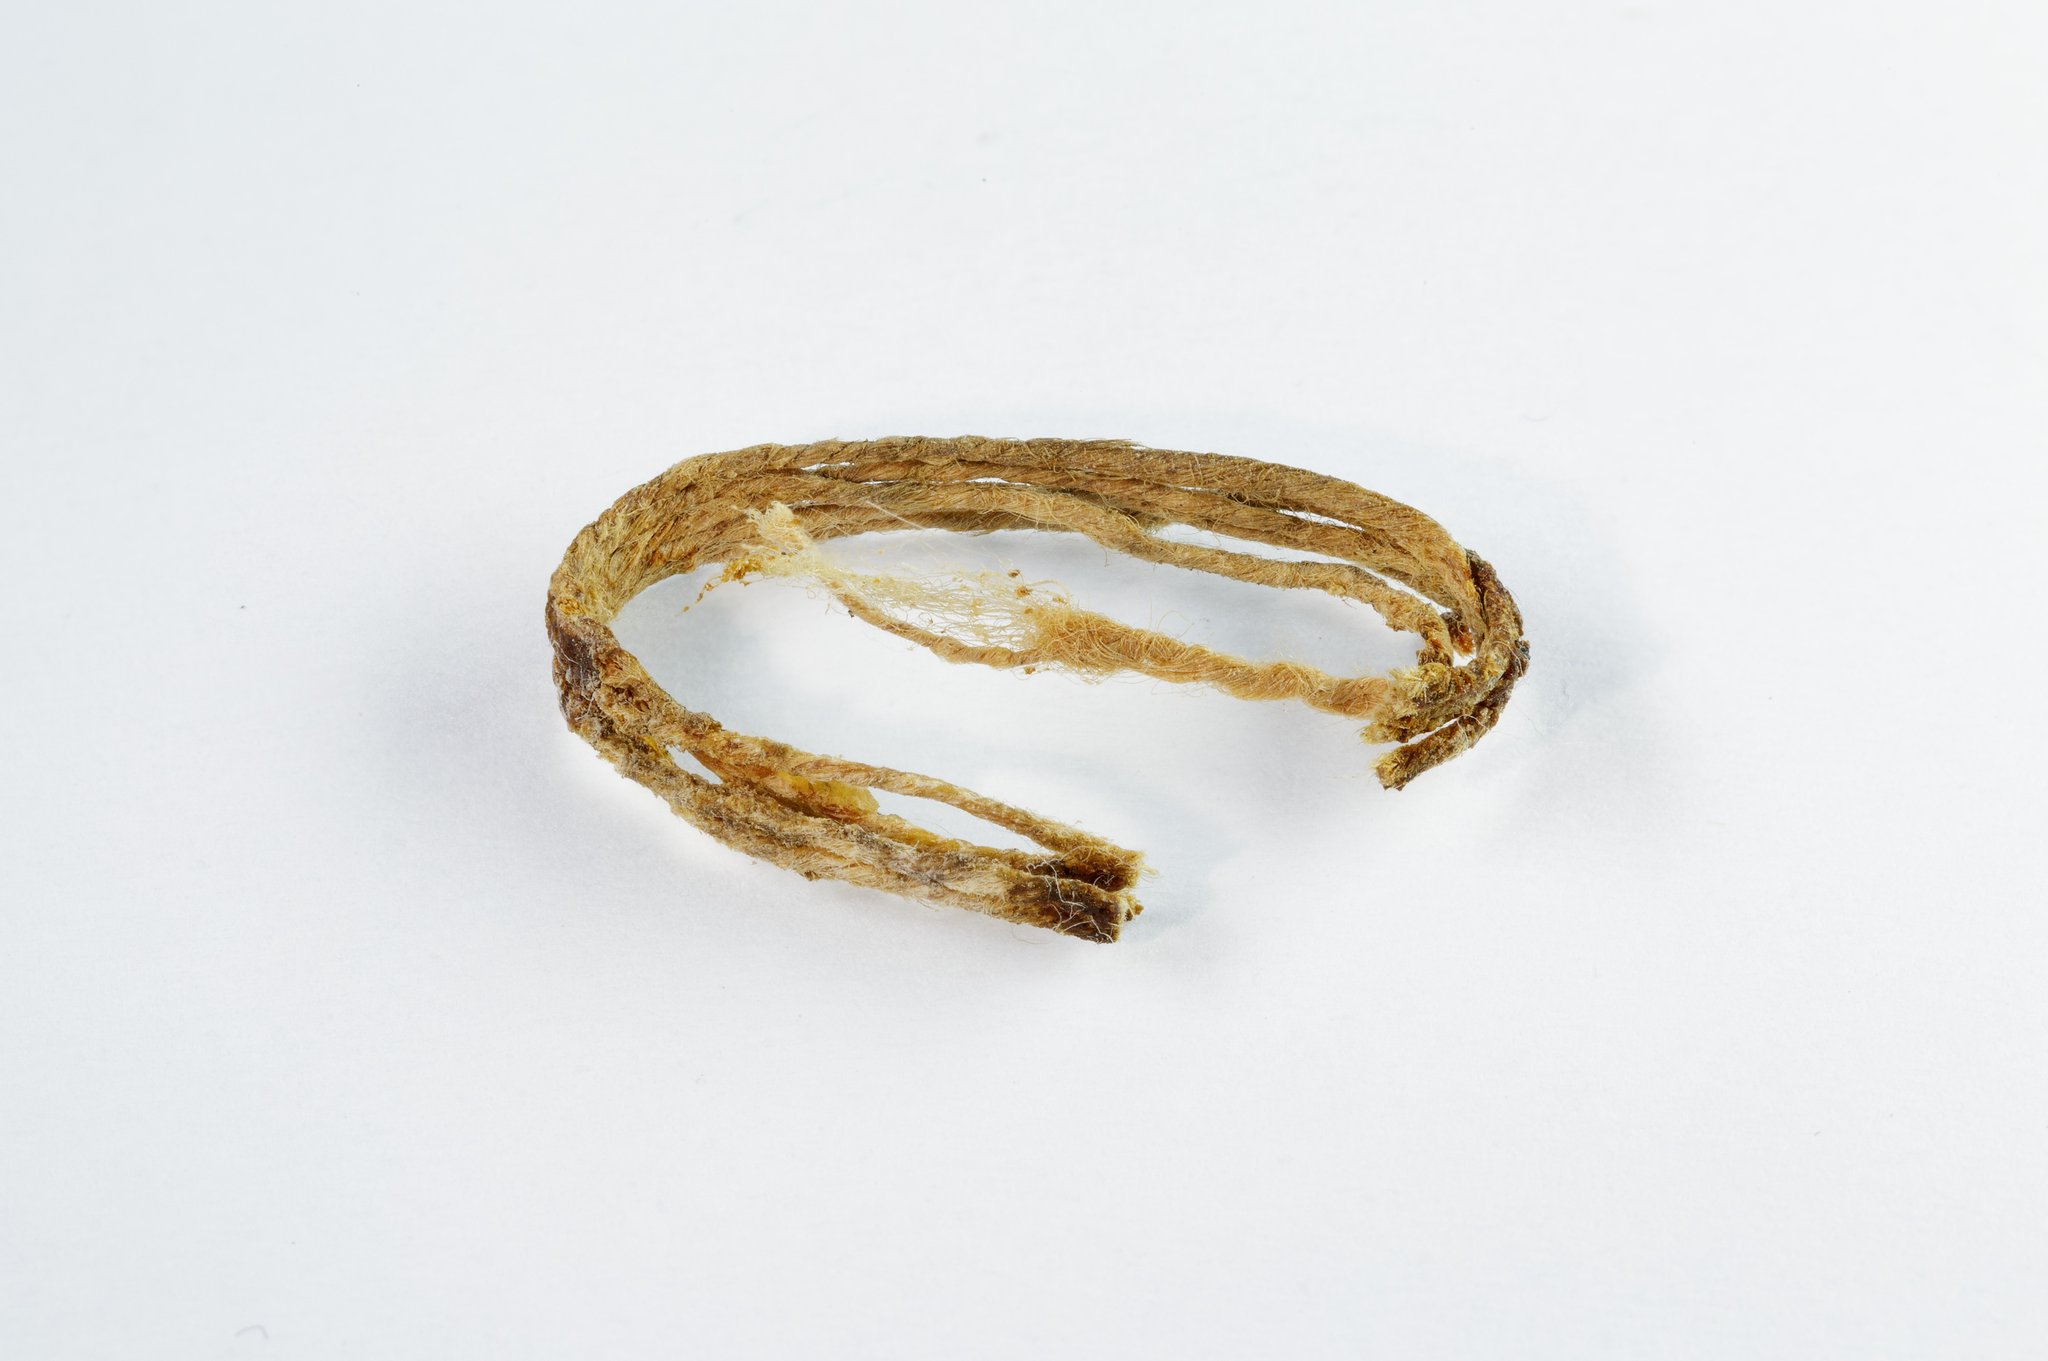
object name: string for papyrus charm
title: String from papyrus charm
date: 1295-1070 BCE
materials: linen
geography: egypt